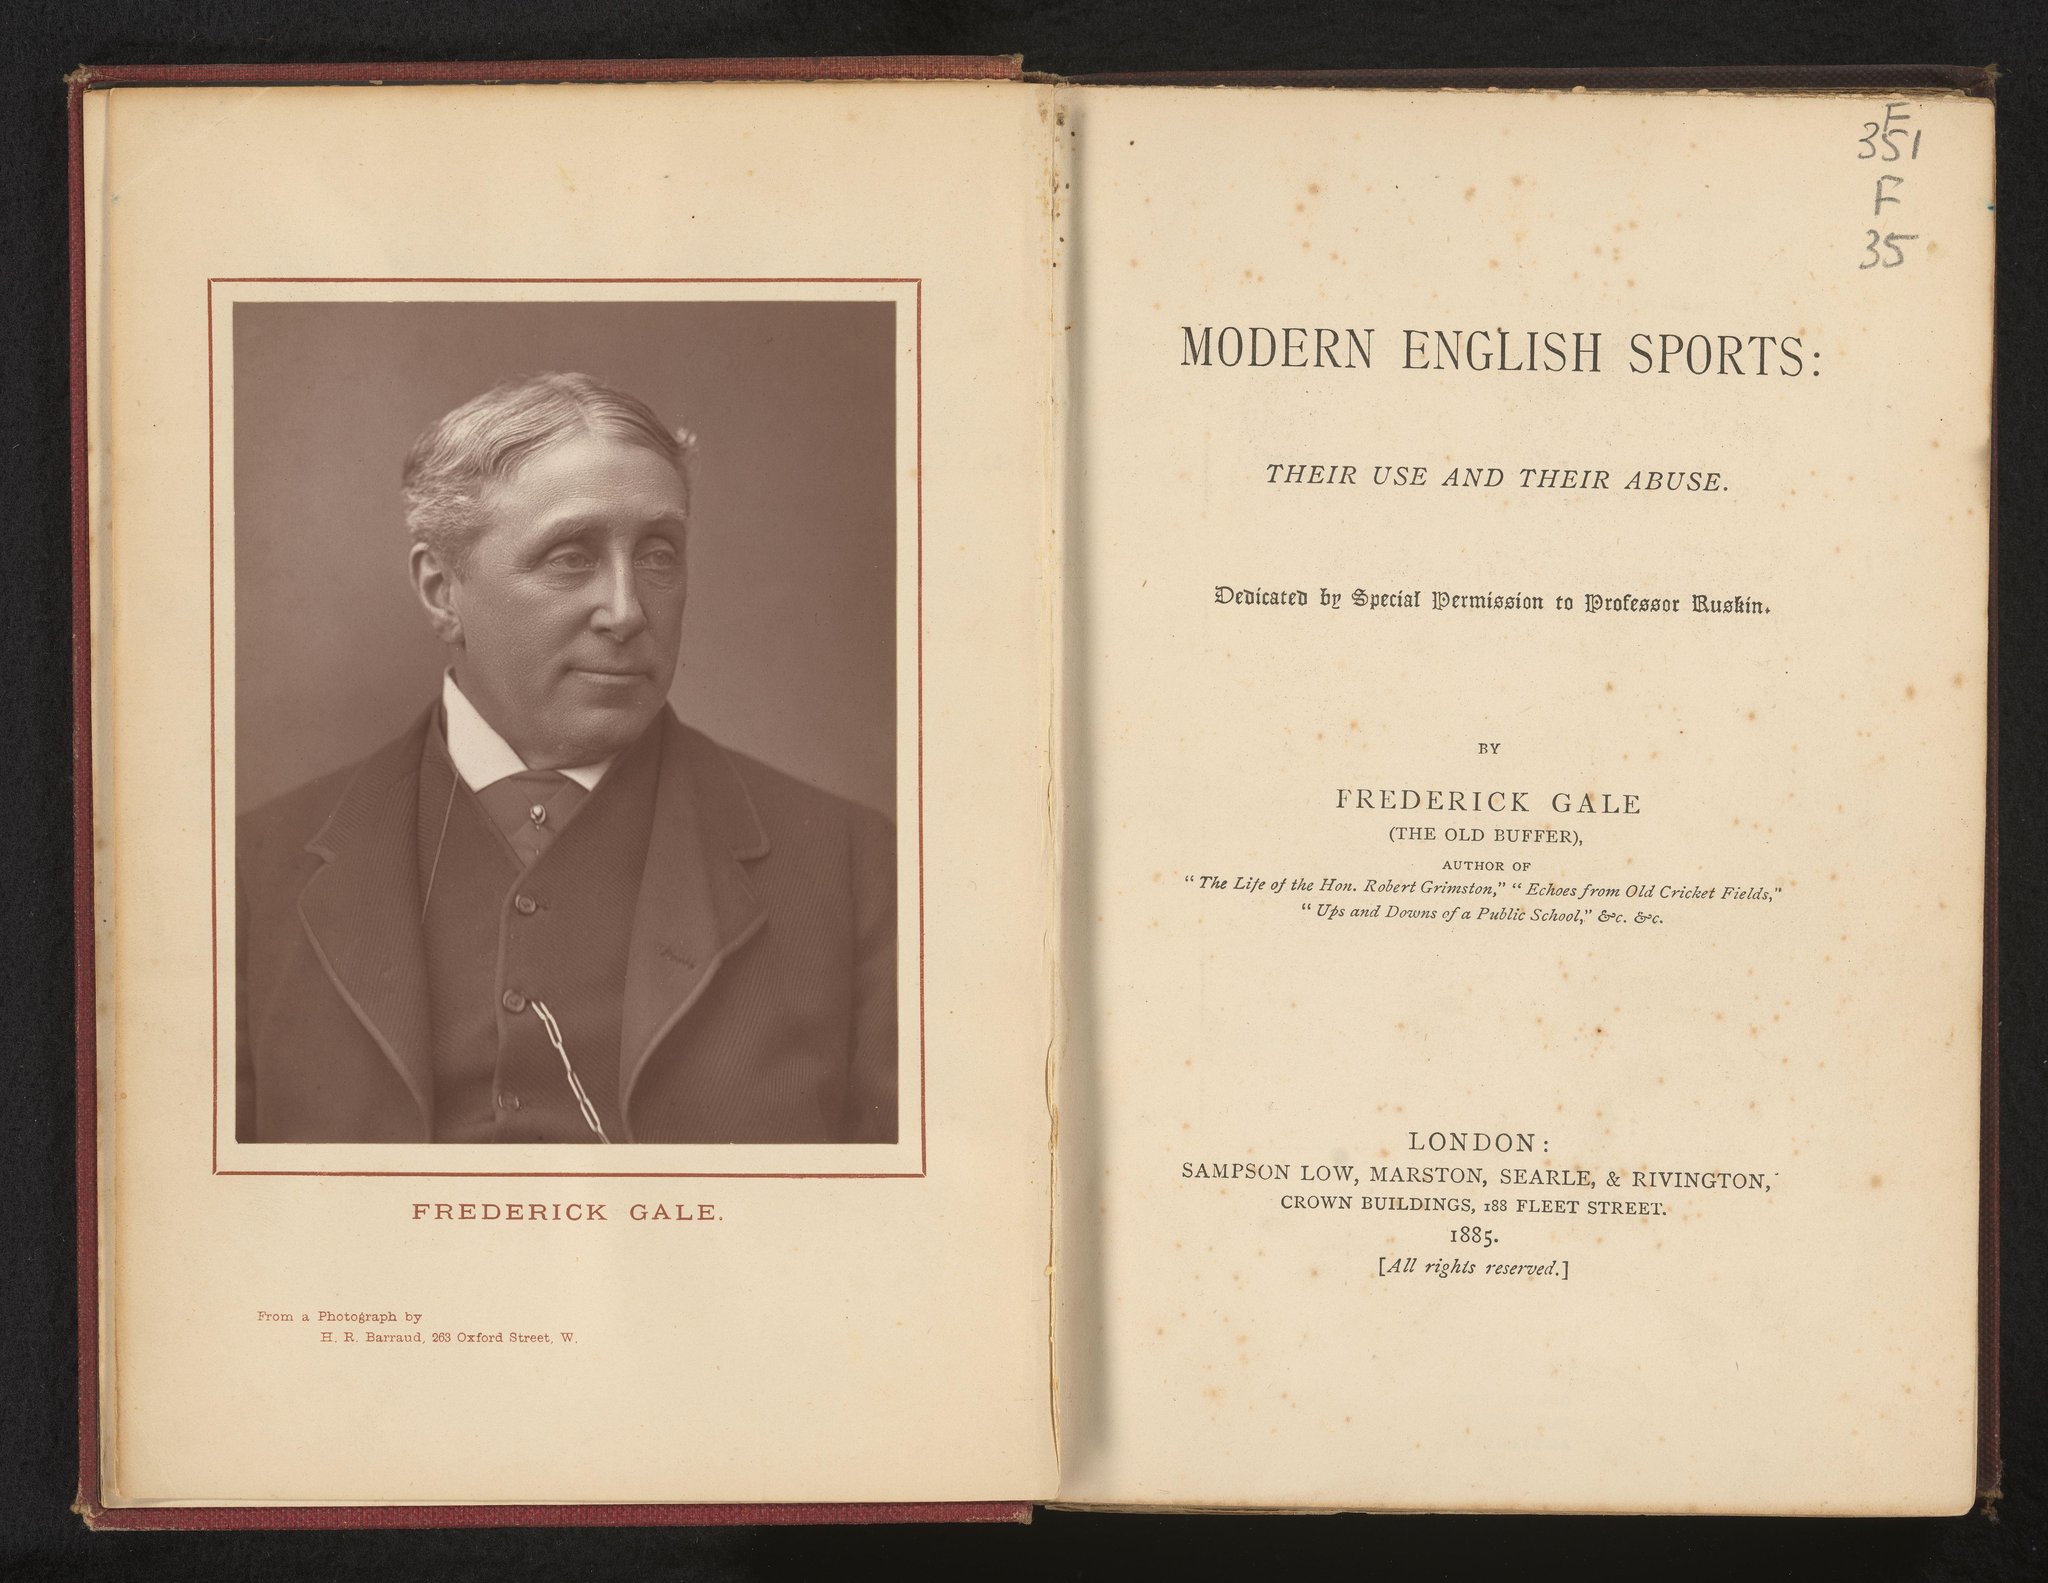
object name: page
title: Portret van de cricketspeler Frederick Gale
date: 1875-1885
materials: paper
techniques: woodburytype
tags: frederick gale, adult man, historical persons